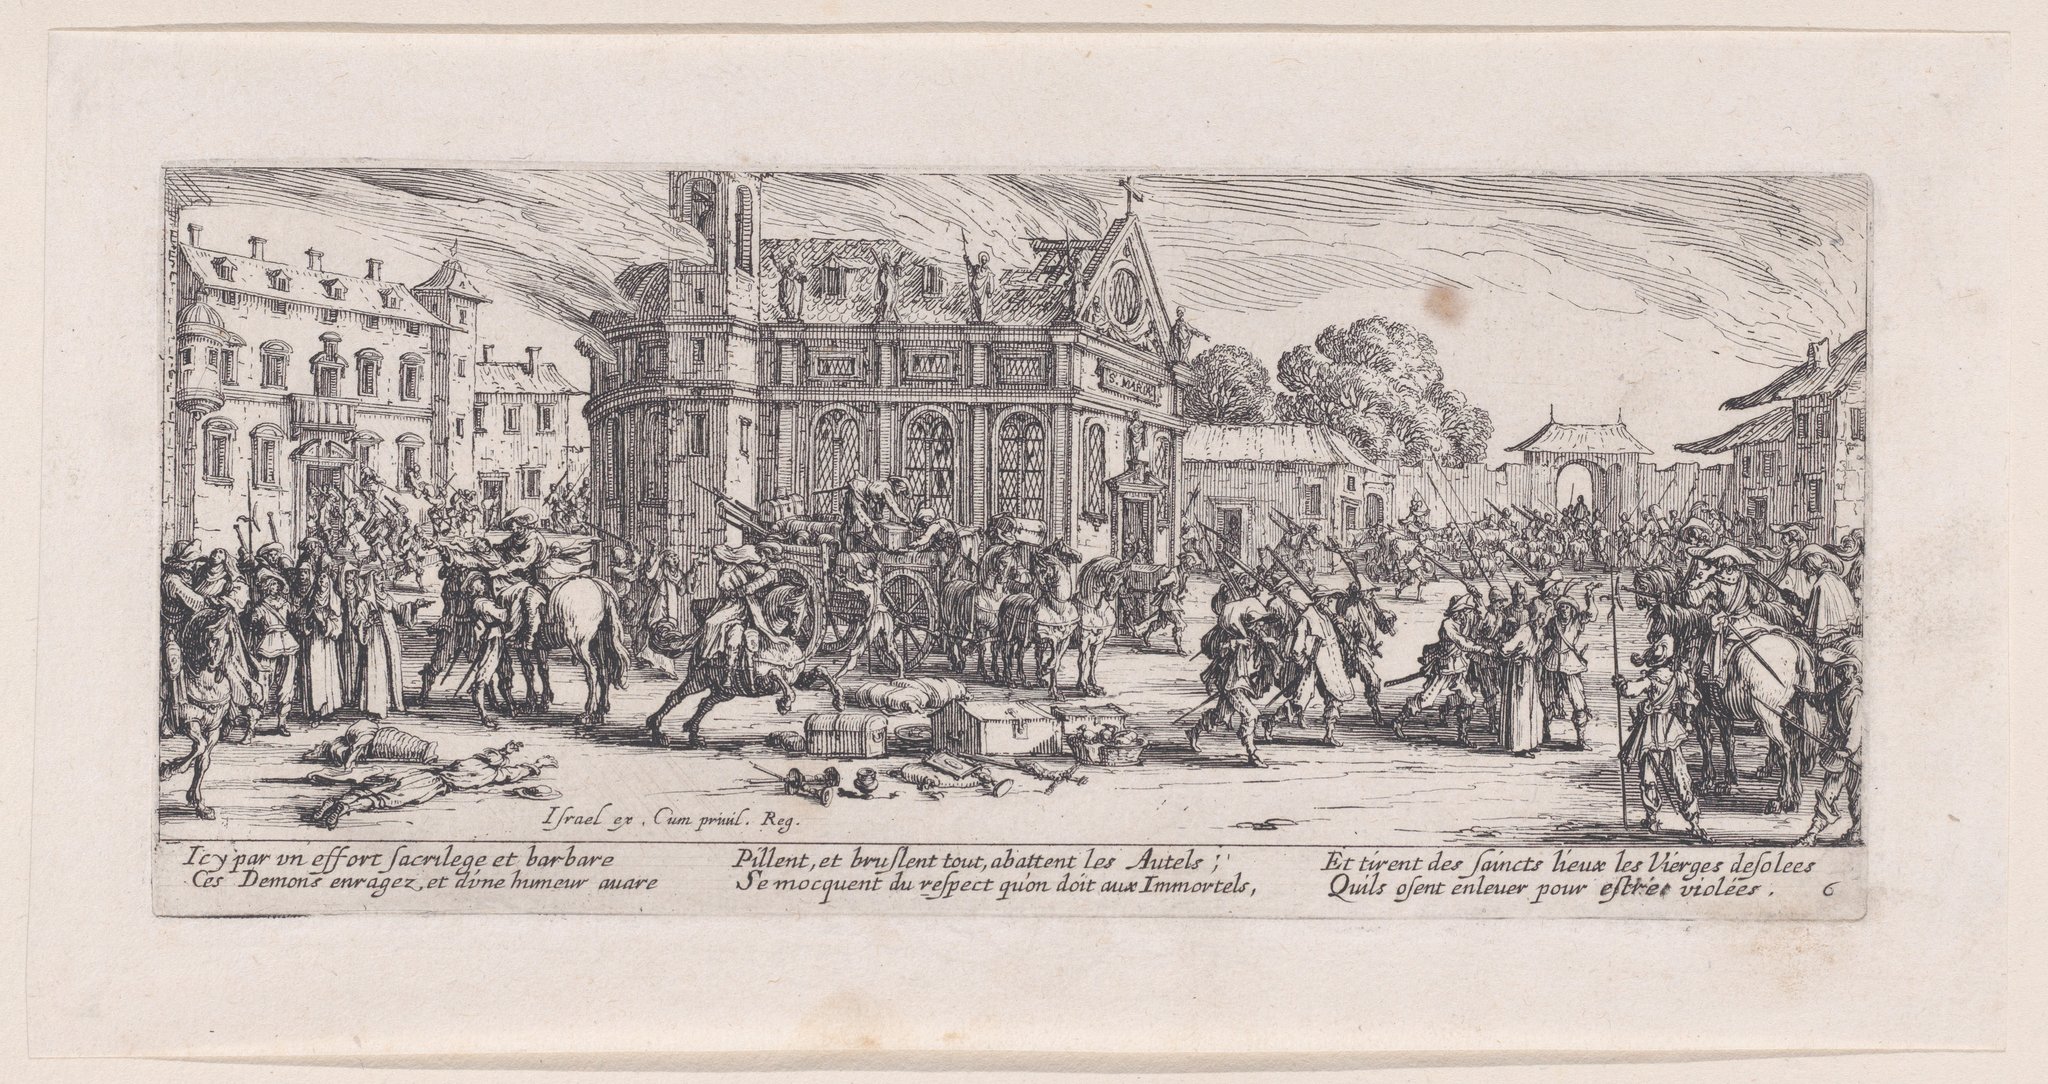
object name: print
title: Dévastation d'un Monastère (Devastation of a Monastery), plate 6 from "Les Misères et les Mal-Heures de la Guerre" (The Miseries and Misfortunes of War)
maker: jacques callot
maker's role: artist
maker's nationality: french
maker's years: 1592-1635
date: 1633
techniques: etching